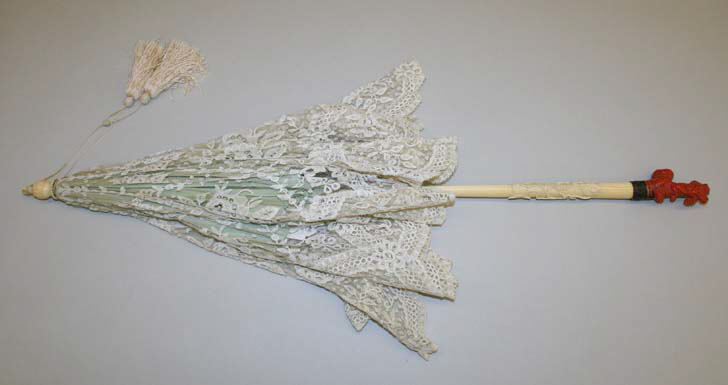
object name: parasol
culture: french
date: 1834-1866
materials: silk